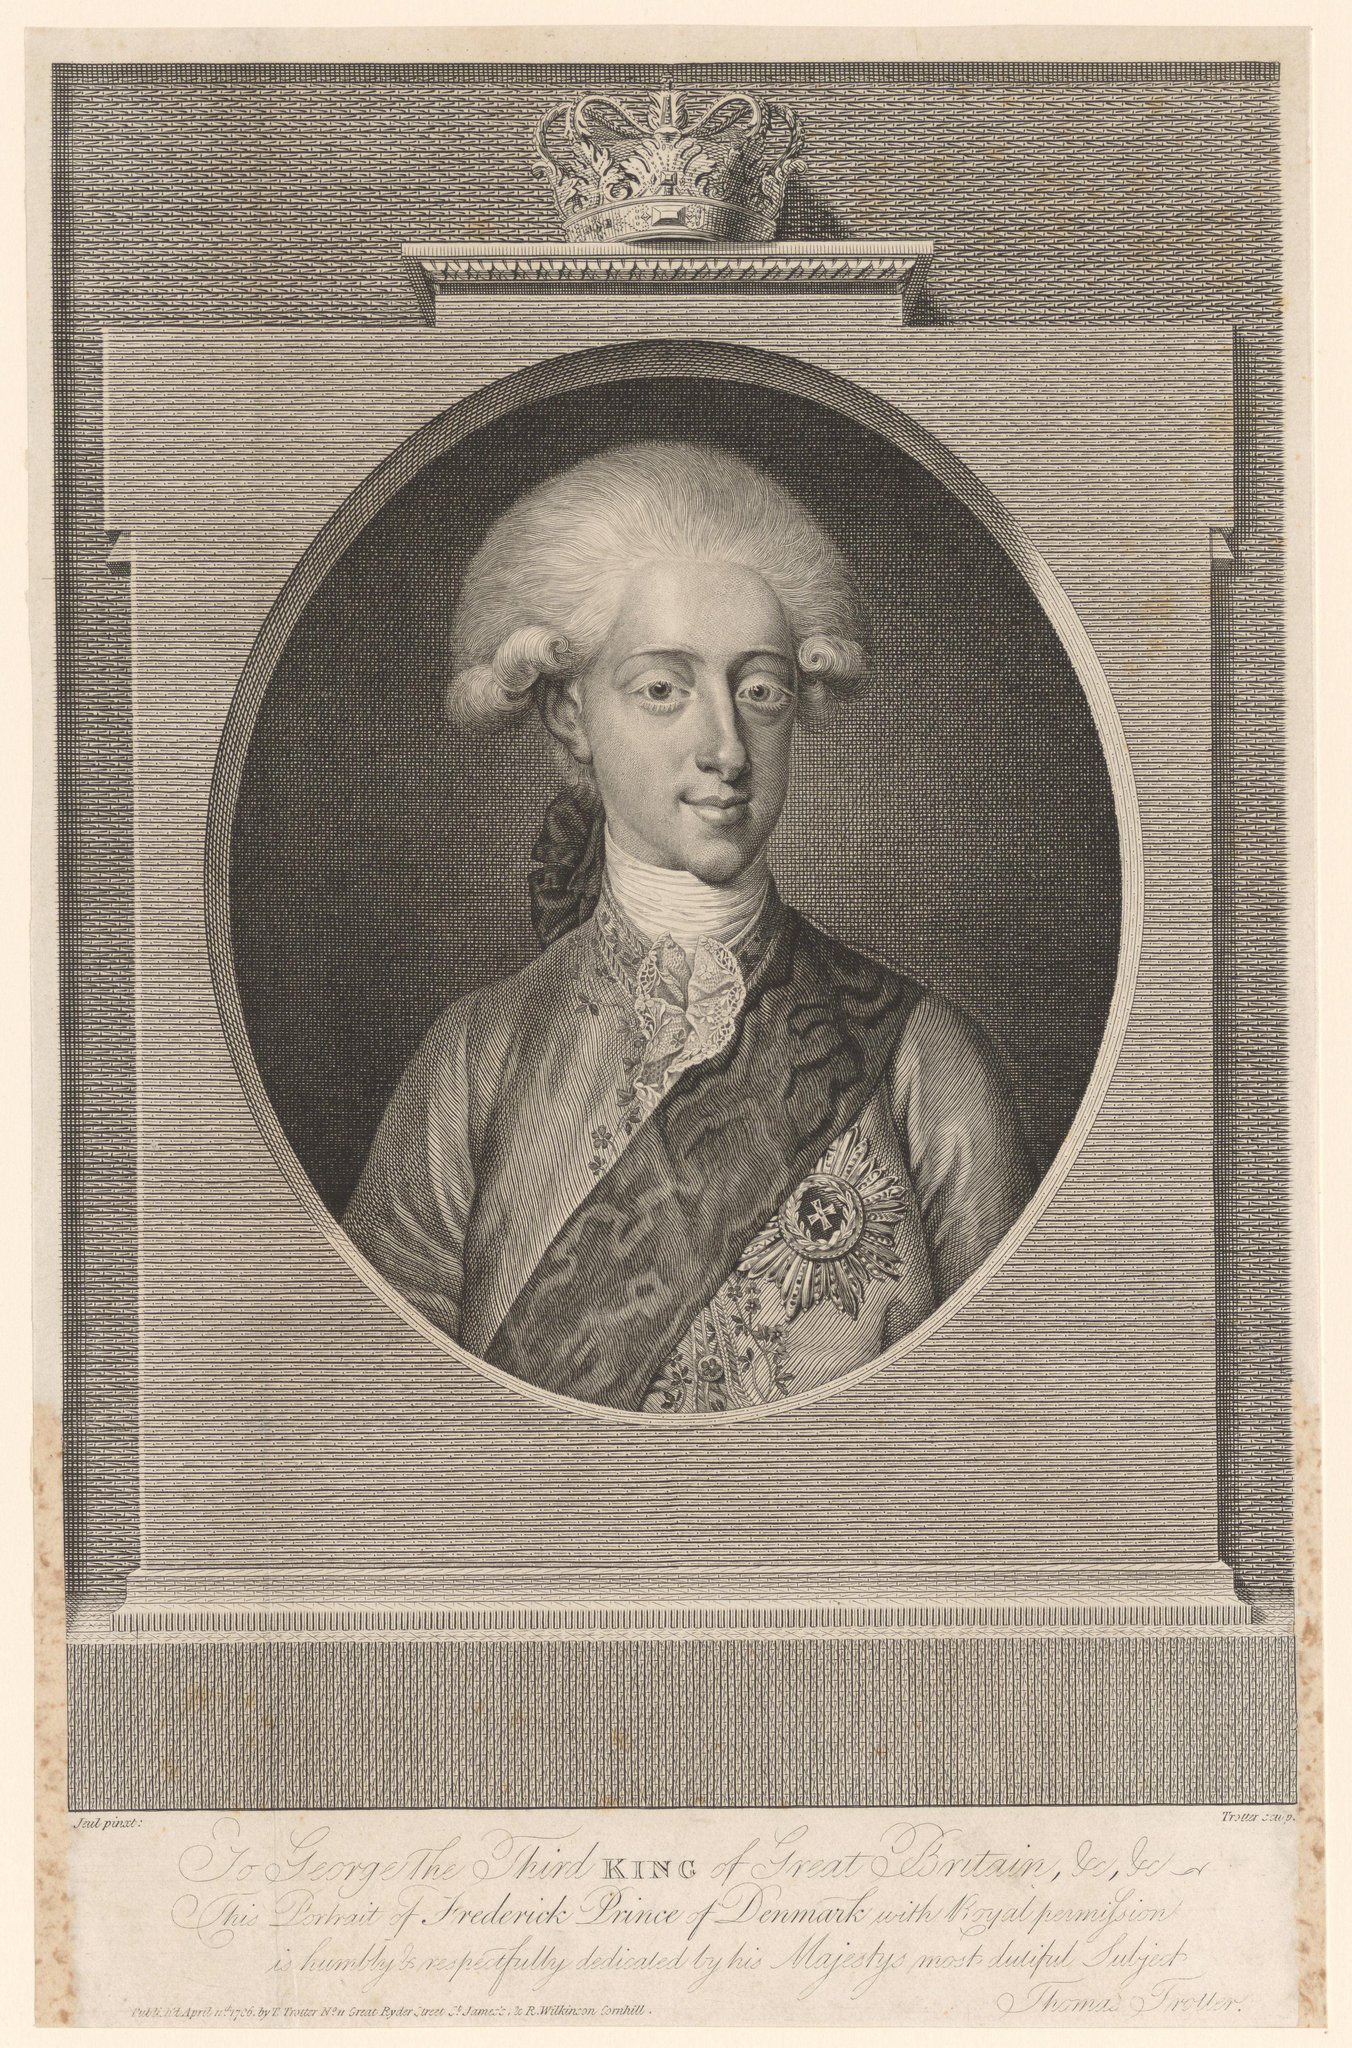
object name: print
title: Frederick Prince of Denmark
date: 1704-1786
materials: paper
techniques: engraving, etching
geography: london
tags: historical persons, regent, substitute ruler; viceroy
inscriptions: collector's mark: Lugt 2228